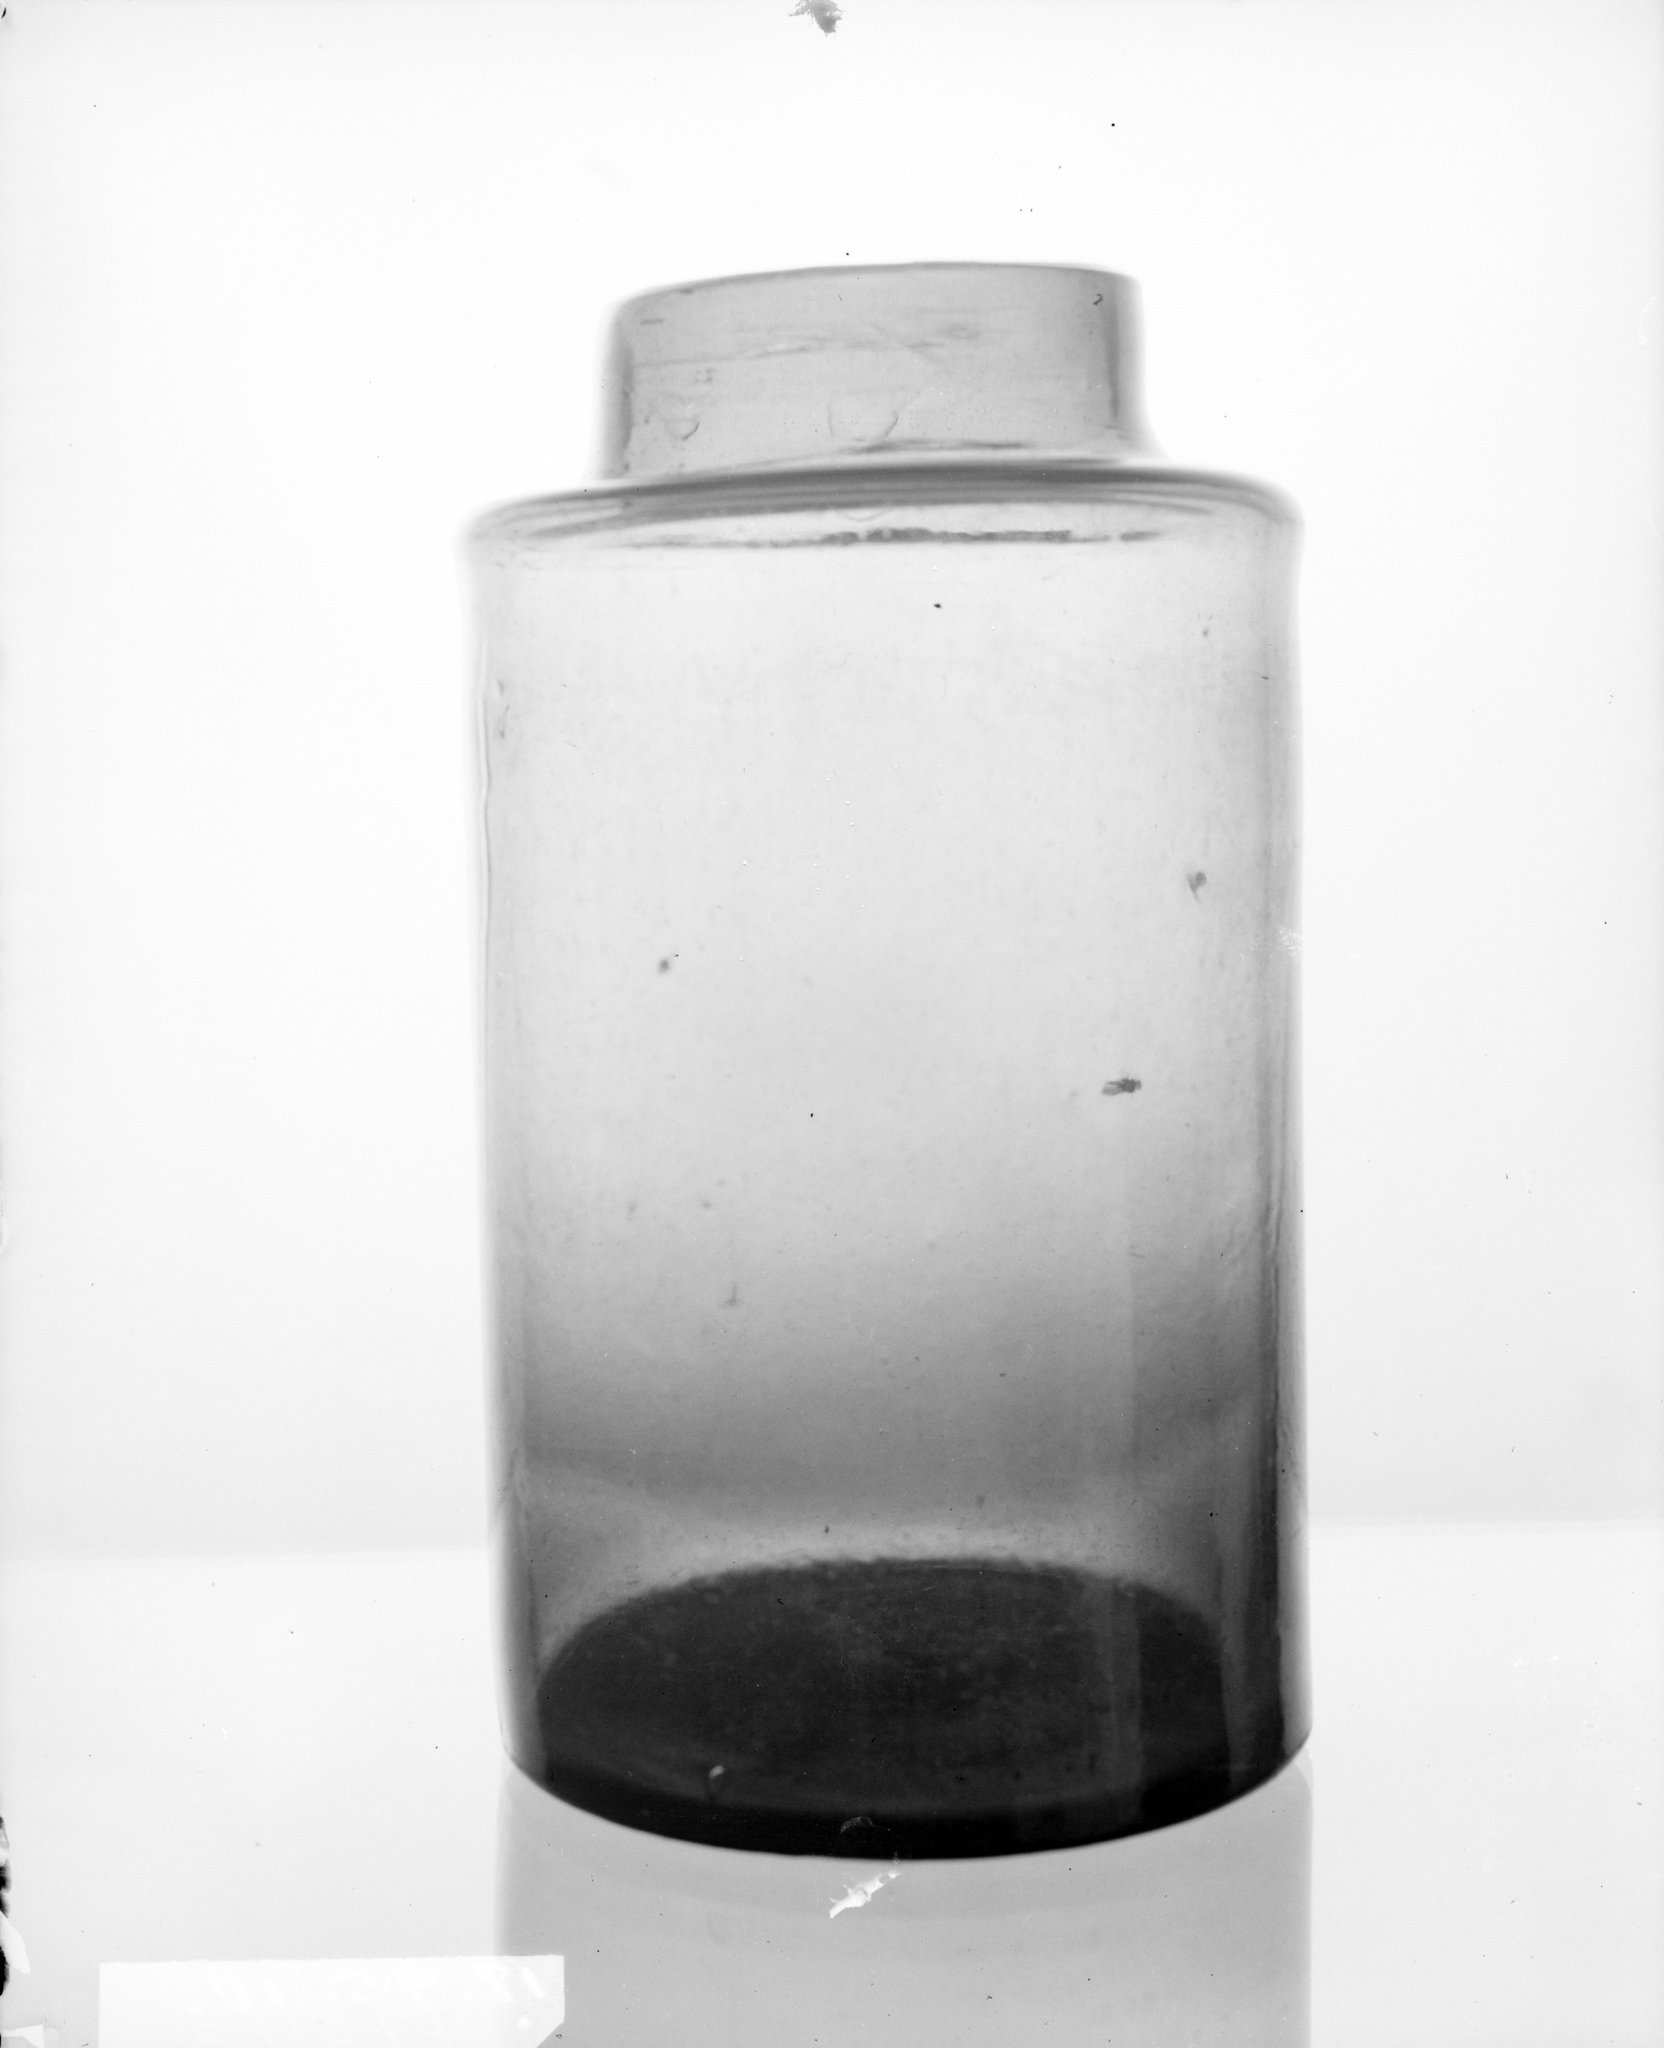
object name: pharmacy jar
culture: american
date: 1830-1870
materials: glass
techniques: glassblowing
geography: united states